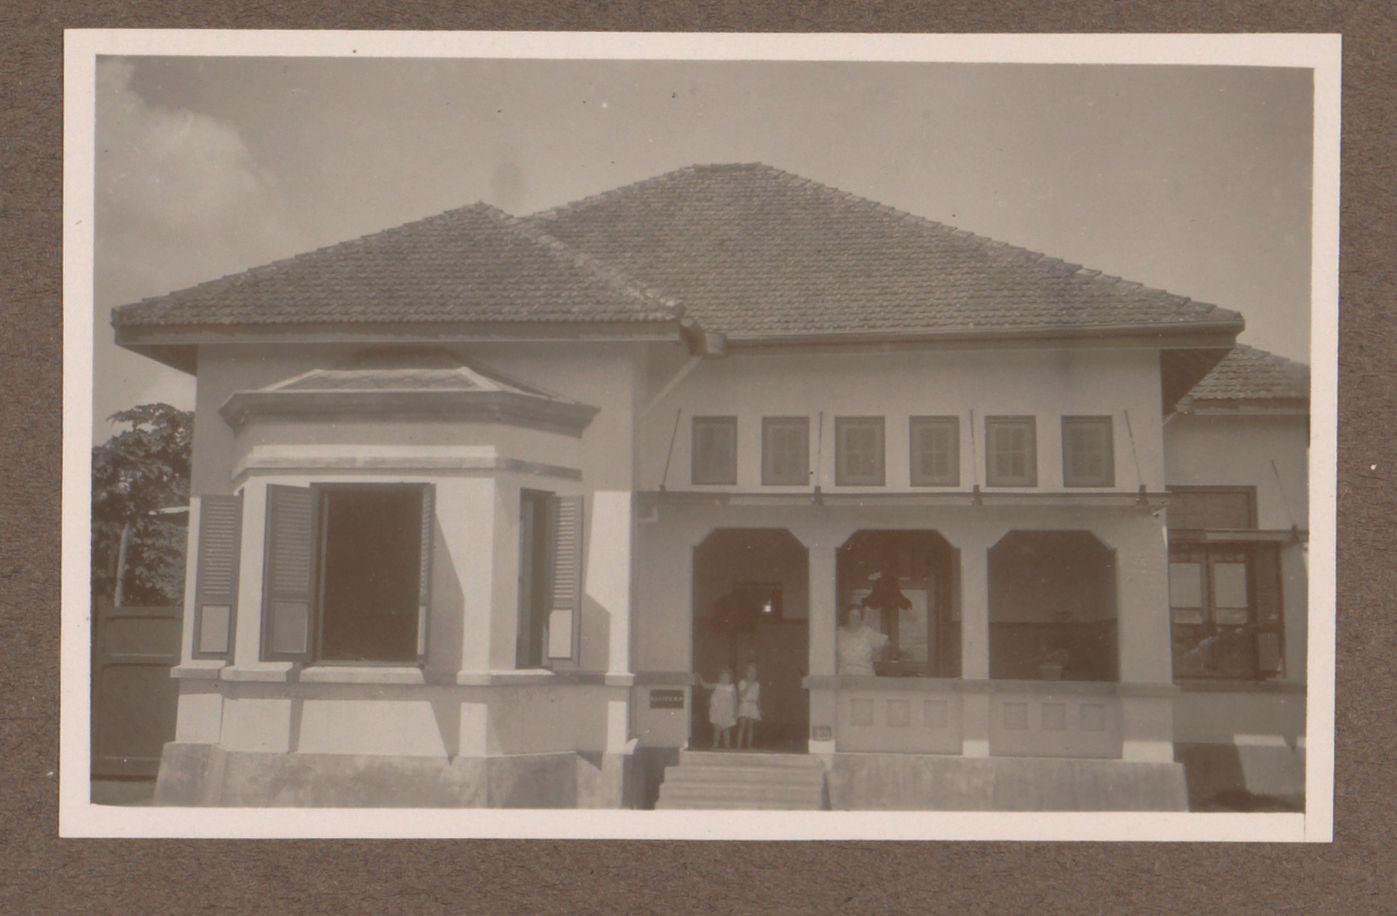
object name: photograph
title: Woning in Nederlands-Indië met (vermoedelijk) mevrouw Kleiterp-Vermeulen en haar kinderen Klaas en Tiny zichtbaar bij de deuropening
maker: klaas kleiterp (i)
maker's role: arts, officier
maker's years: 1892-1943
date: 1920-1930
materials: paper, photographic support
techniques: gelatin silver print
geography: dutch east indies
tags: rural housing, e.g. country-house, villa, cottage, façade (of house or building), dutch east indies, the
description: Onderdeel van Fotoalbum van de familie Kleiterp-Vermeulen met opnames van Nederlands-Indië.